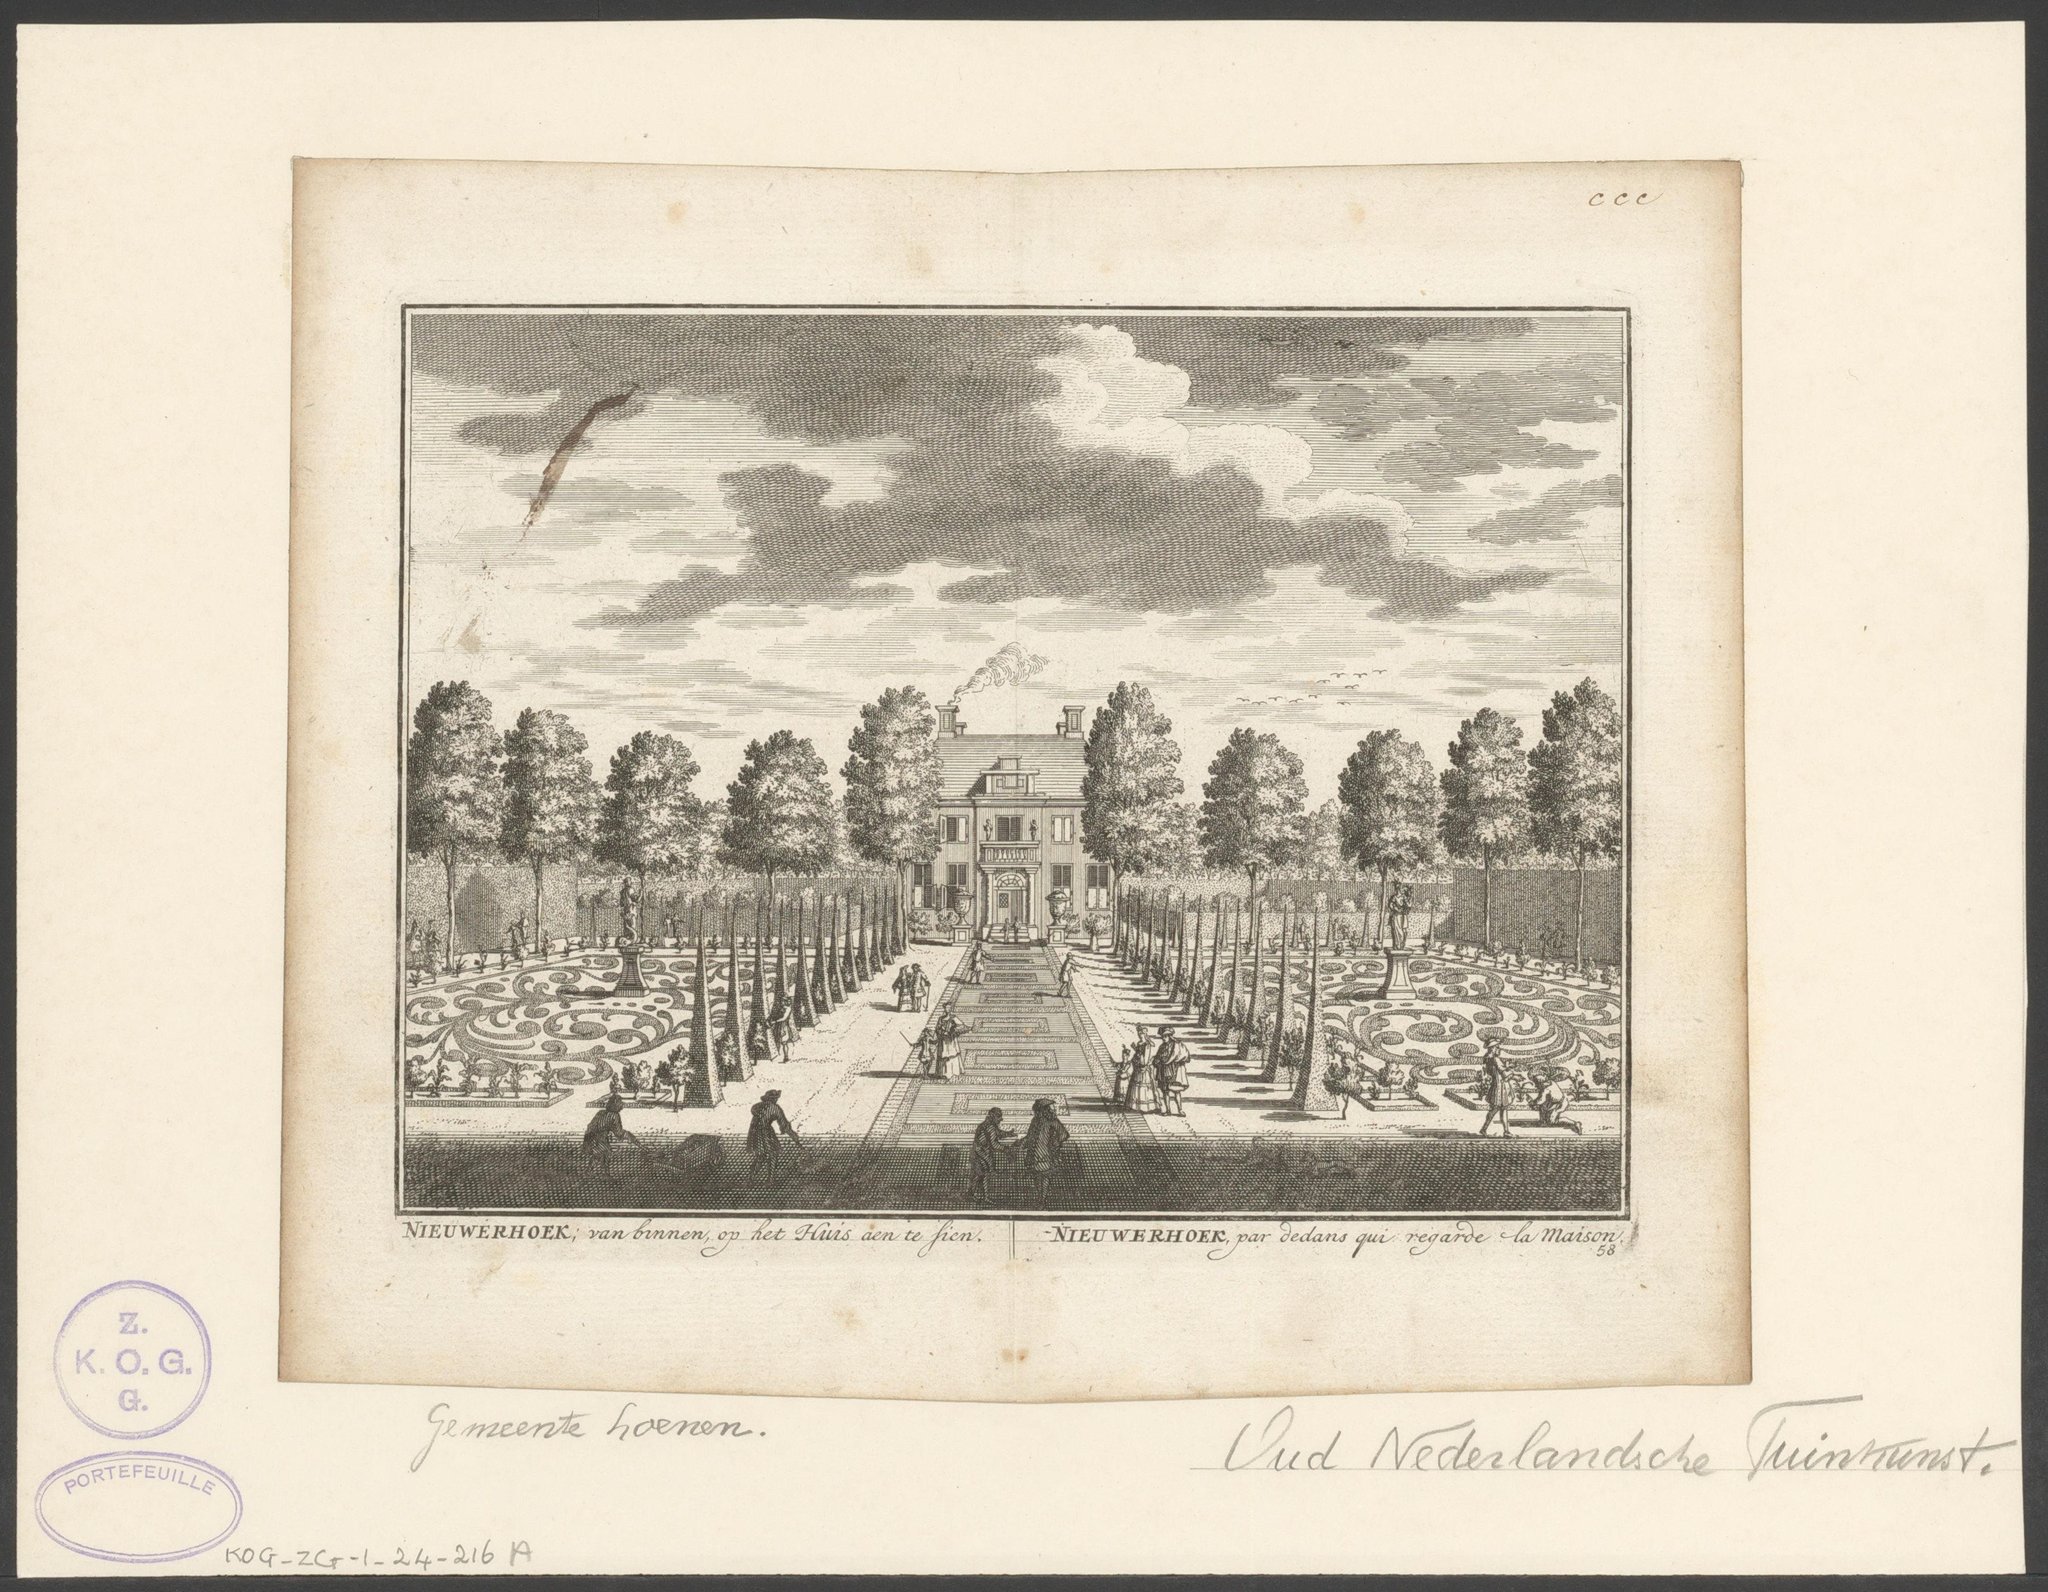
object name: print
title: Gezicht op de tuin van de buitenplaats Nieuwerhoek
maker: daniël stopendaal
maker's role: print maker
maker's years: 1672-1726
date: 1719-1790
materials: paper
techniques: engraving, etching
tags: french or architectonic garden; formal garden, river (+ landscape with figures, staffage), country-house, vecht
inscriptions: collector's mark: Lugt 1641, stamp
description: Prent voor het eerst gebruikt in: Leth, Andries de. De zegepraalende Vecht, vertoonende verscheidene gesichten van lustplaatsen, heeren huysen en dorpen, beginnende van Uitrecht en met Muyden besluytende (...). Amsterdam: Weduwe Nicolaus Visscher, 1719. Prent mogelijk uit: Brouërius van Nidek, Matthaeus. De Vechtstroom, van Utrecht tot Muiden (...). Amsterdam: H. Gartman, W. Vermandel en J.W. Smit, 1790.